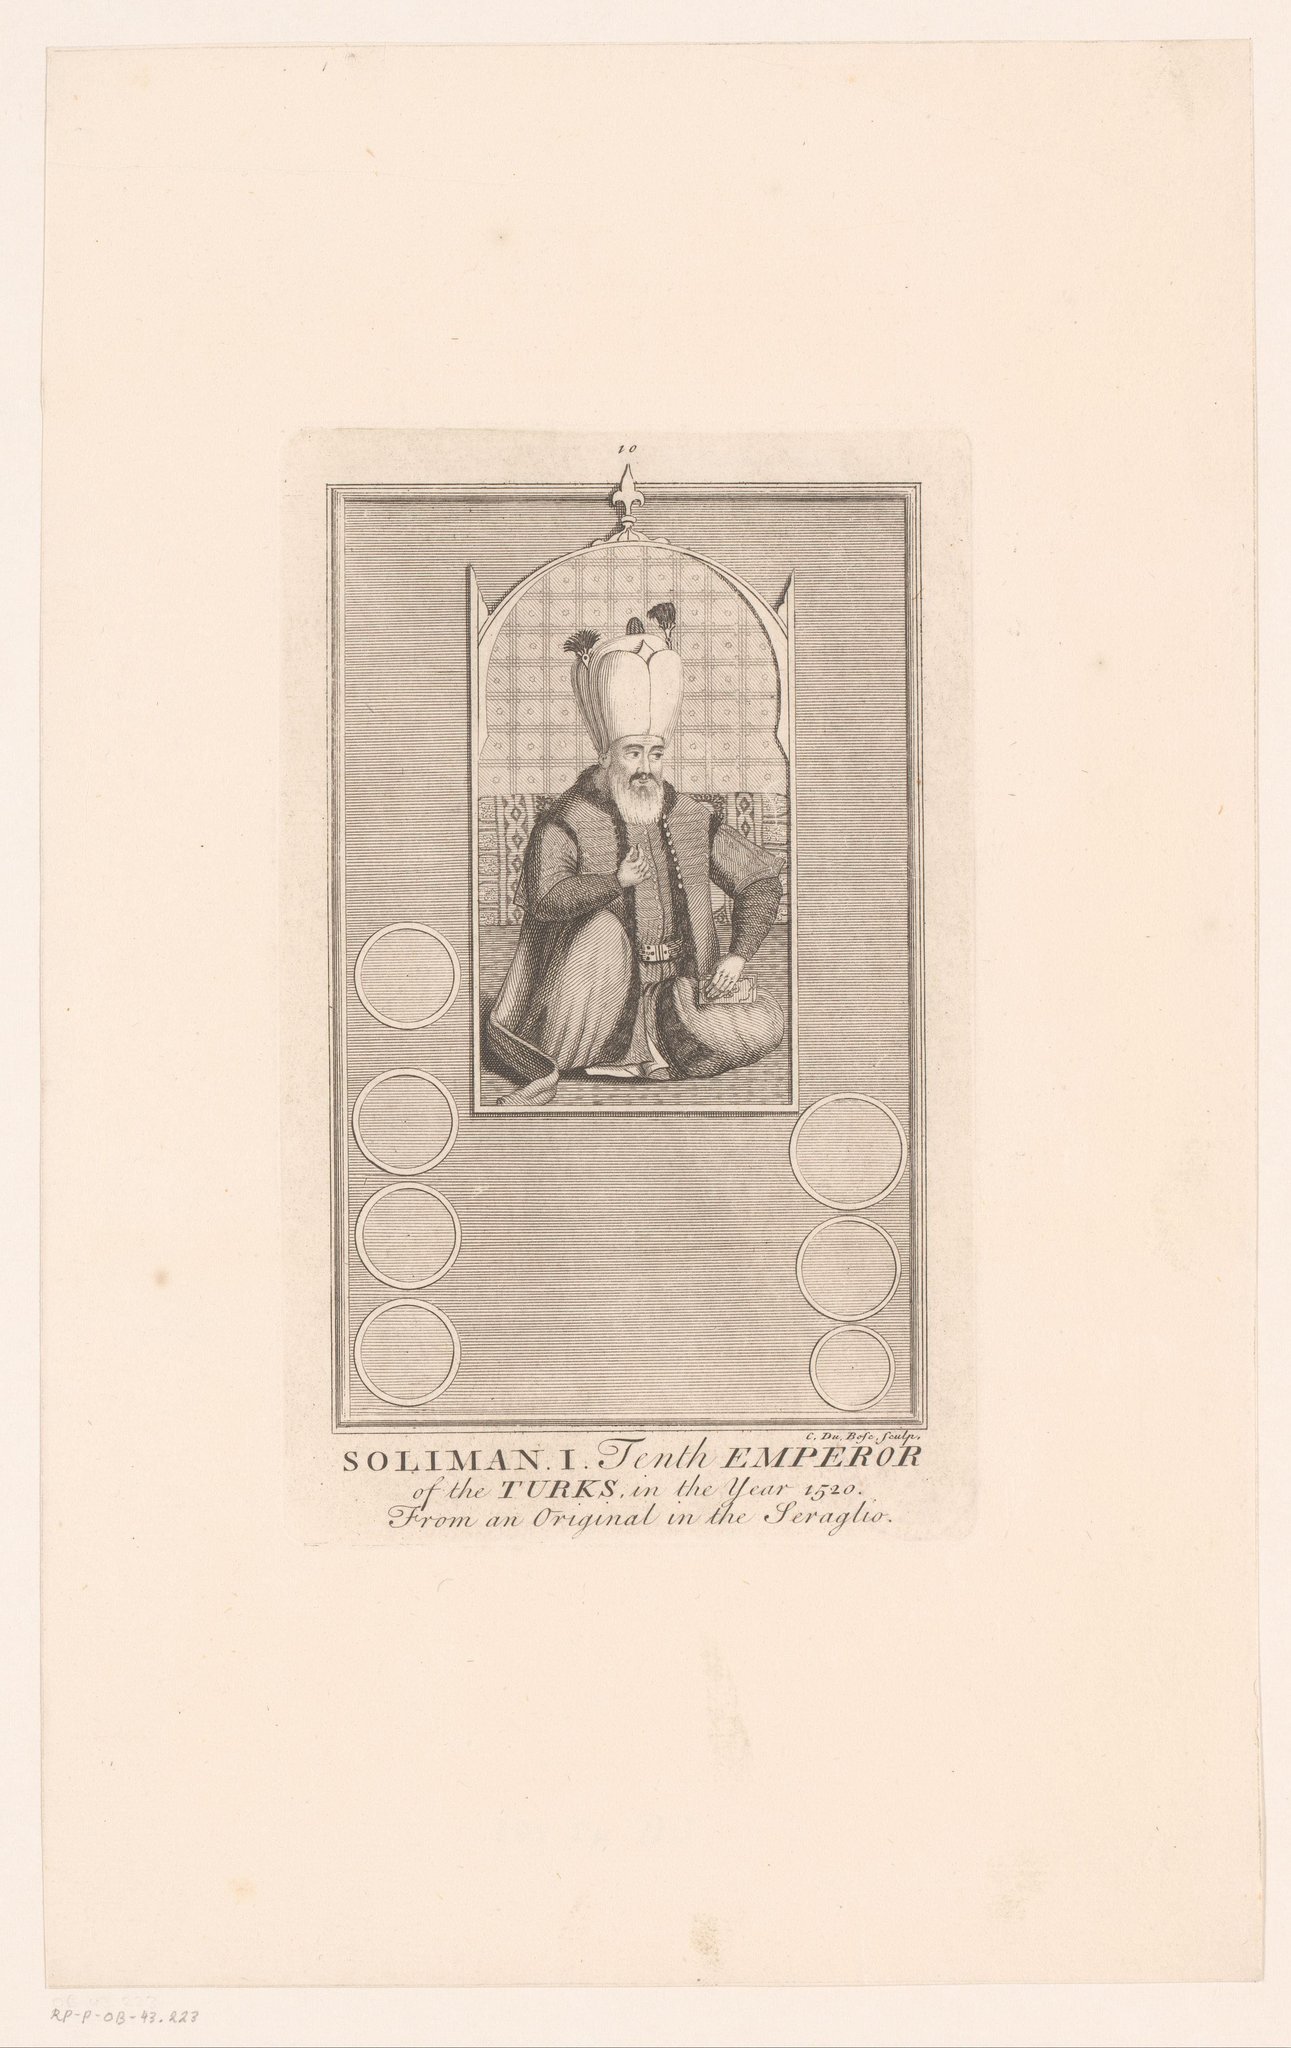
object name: print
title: Portret van Süleyman I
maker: claude dubosc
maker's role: print maker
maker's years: 1682-1745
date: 1692-1745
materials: paper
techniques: engraving, etching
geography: france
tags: historical persons, ruler, sovereign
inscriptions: collector's mark: Lugt 240